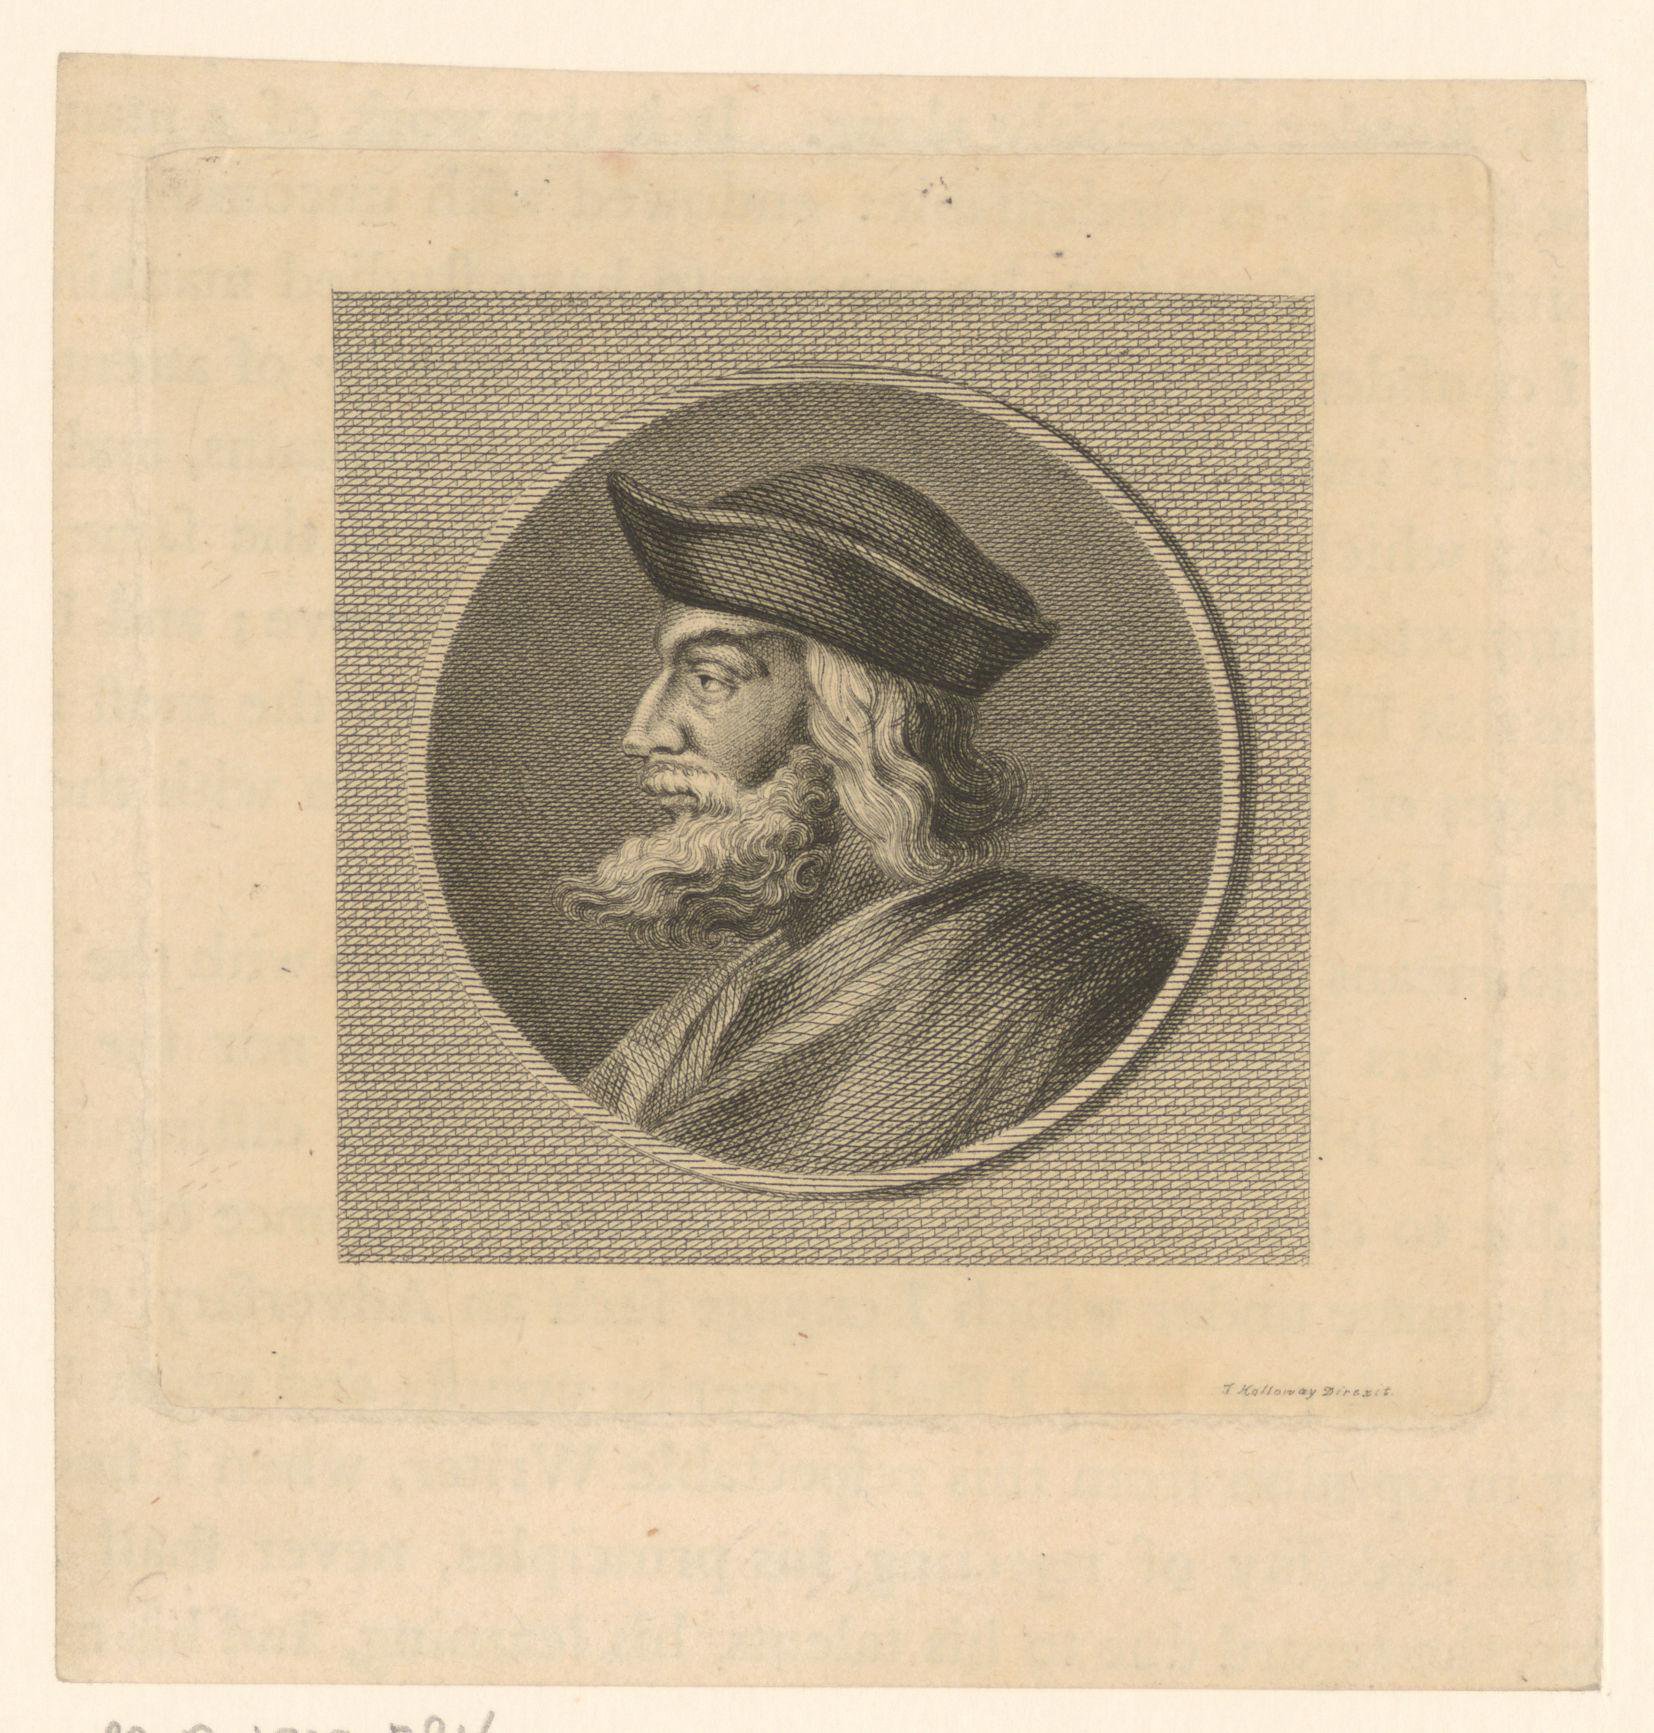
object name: print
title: Hoofd in profiel van man met baard en hoofddeksel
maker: thomas holloway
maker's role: print maker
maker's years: 1748-1827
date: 1758-1827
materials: paper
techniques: etching, letterpress printing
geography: london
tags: head (human) (+ sideview, profile)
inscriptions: collector's mark: Lugt 2228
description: Prent komt uit een niet geïdentificeerde publicatie.